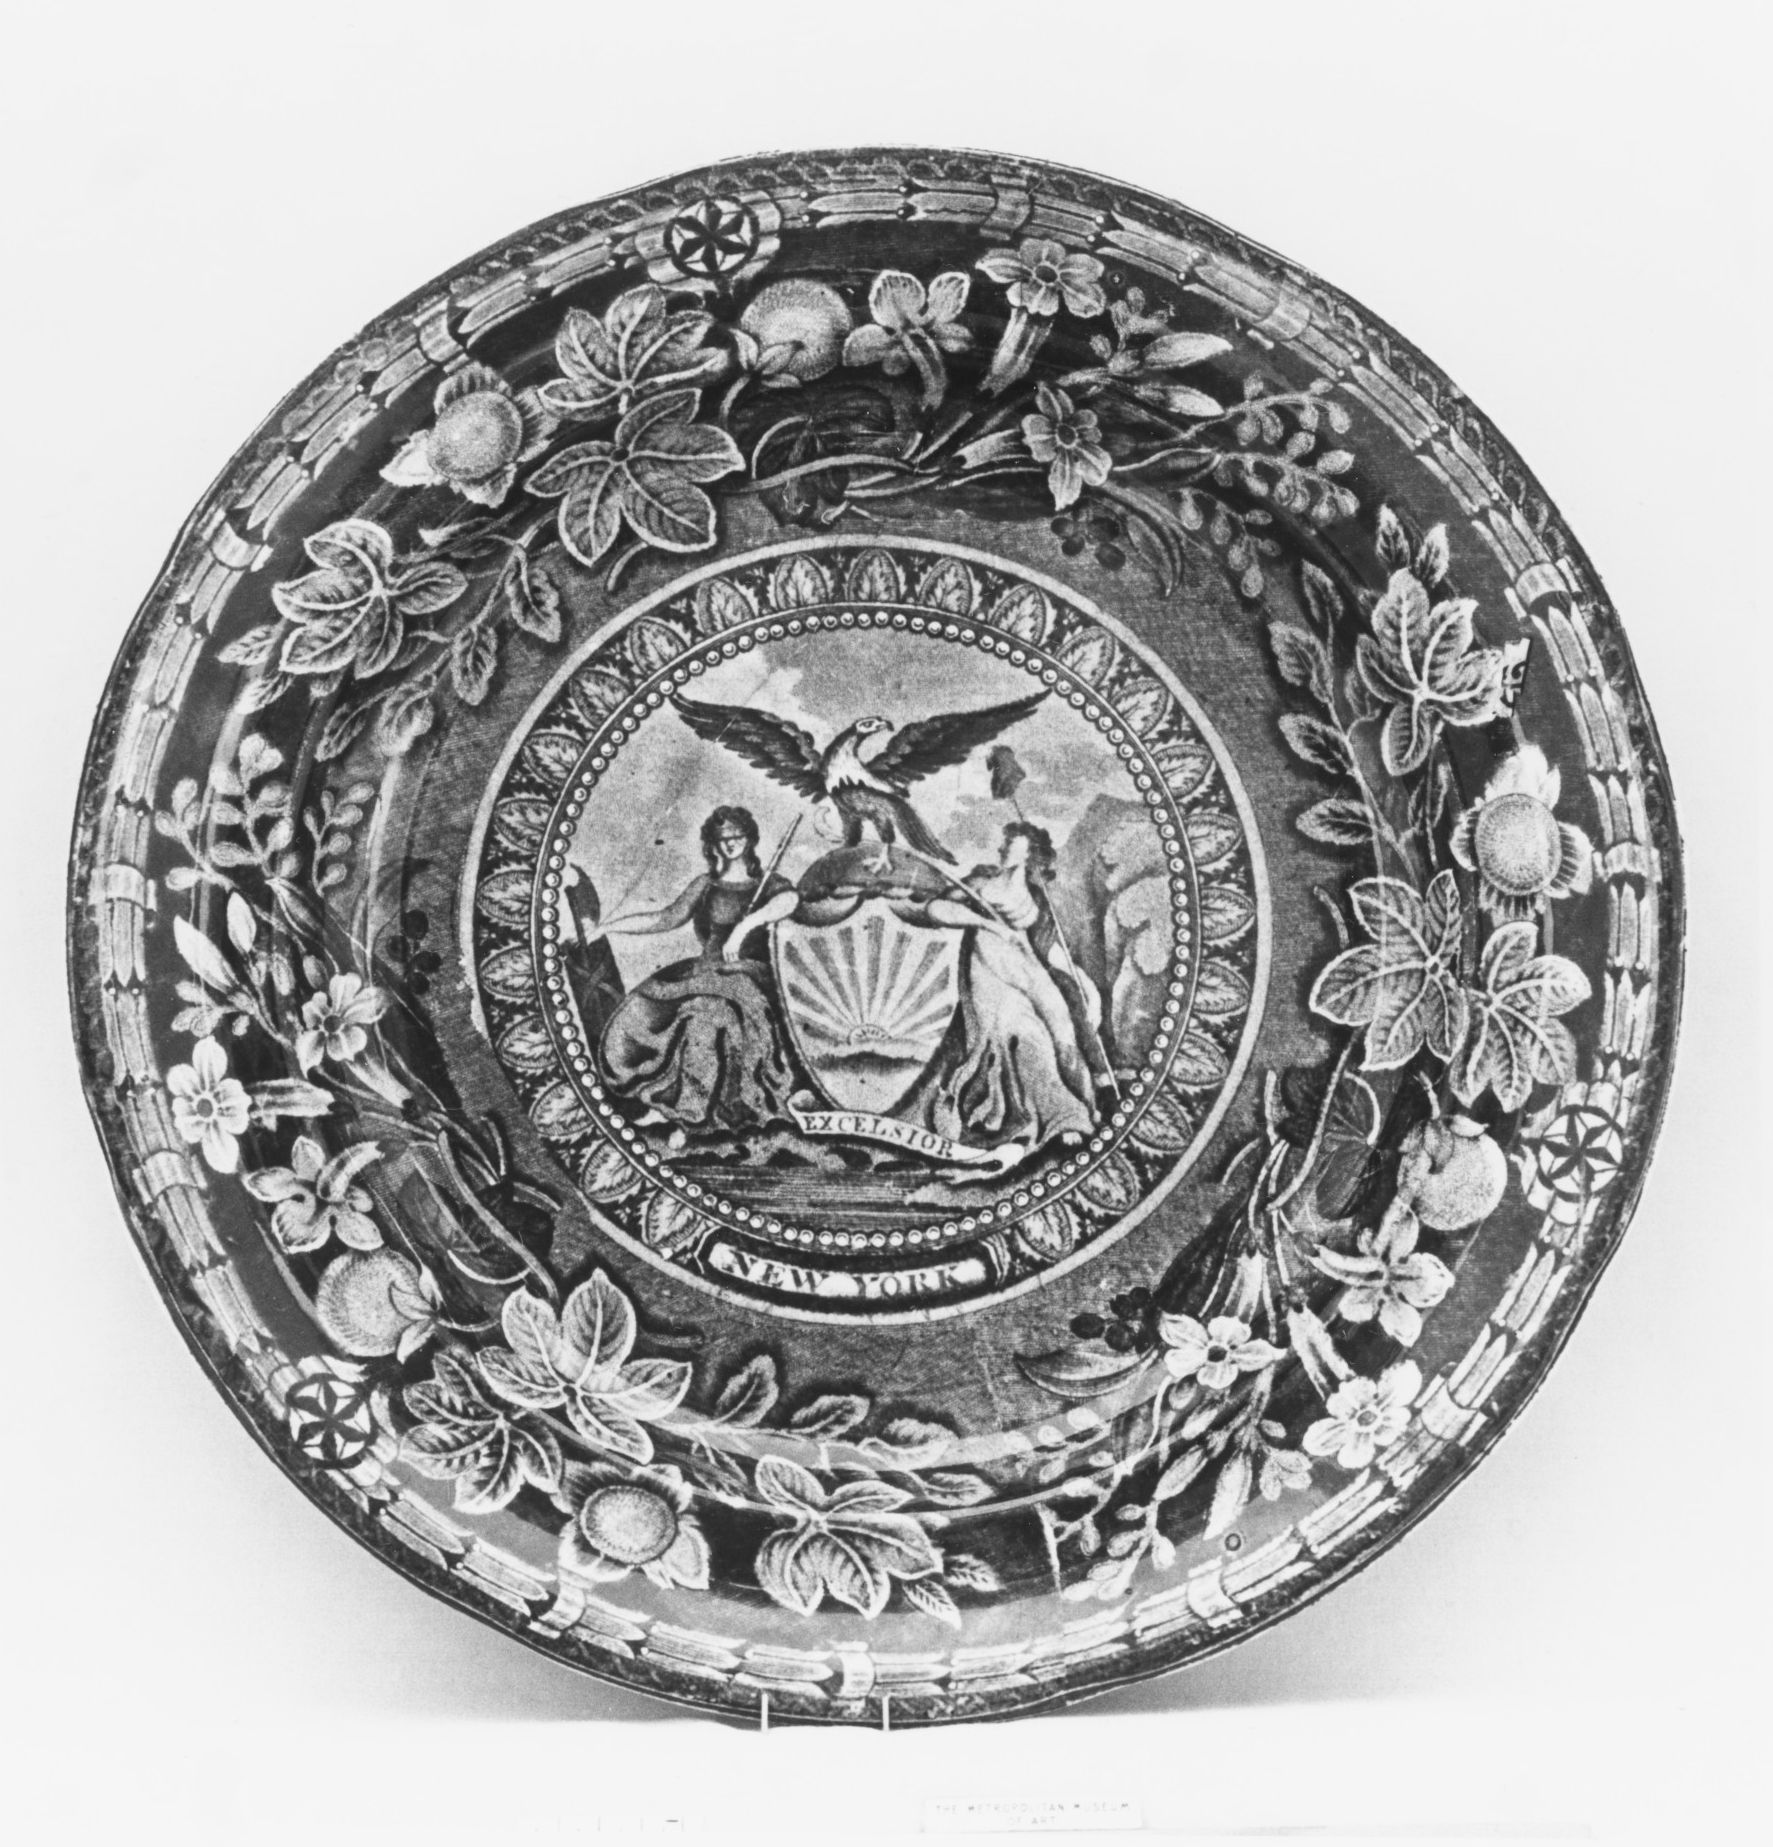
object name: plate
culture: british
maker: thomas mayer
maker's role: maker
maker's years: 1823-1838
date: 1826-1835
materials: earthenware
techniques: transfer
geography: england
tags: birds,women,flowers